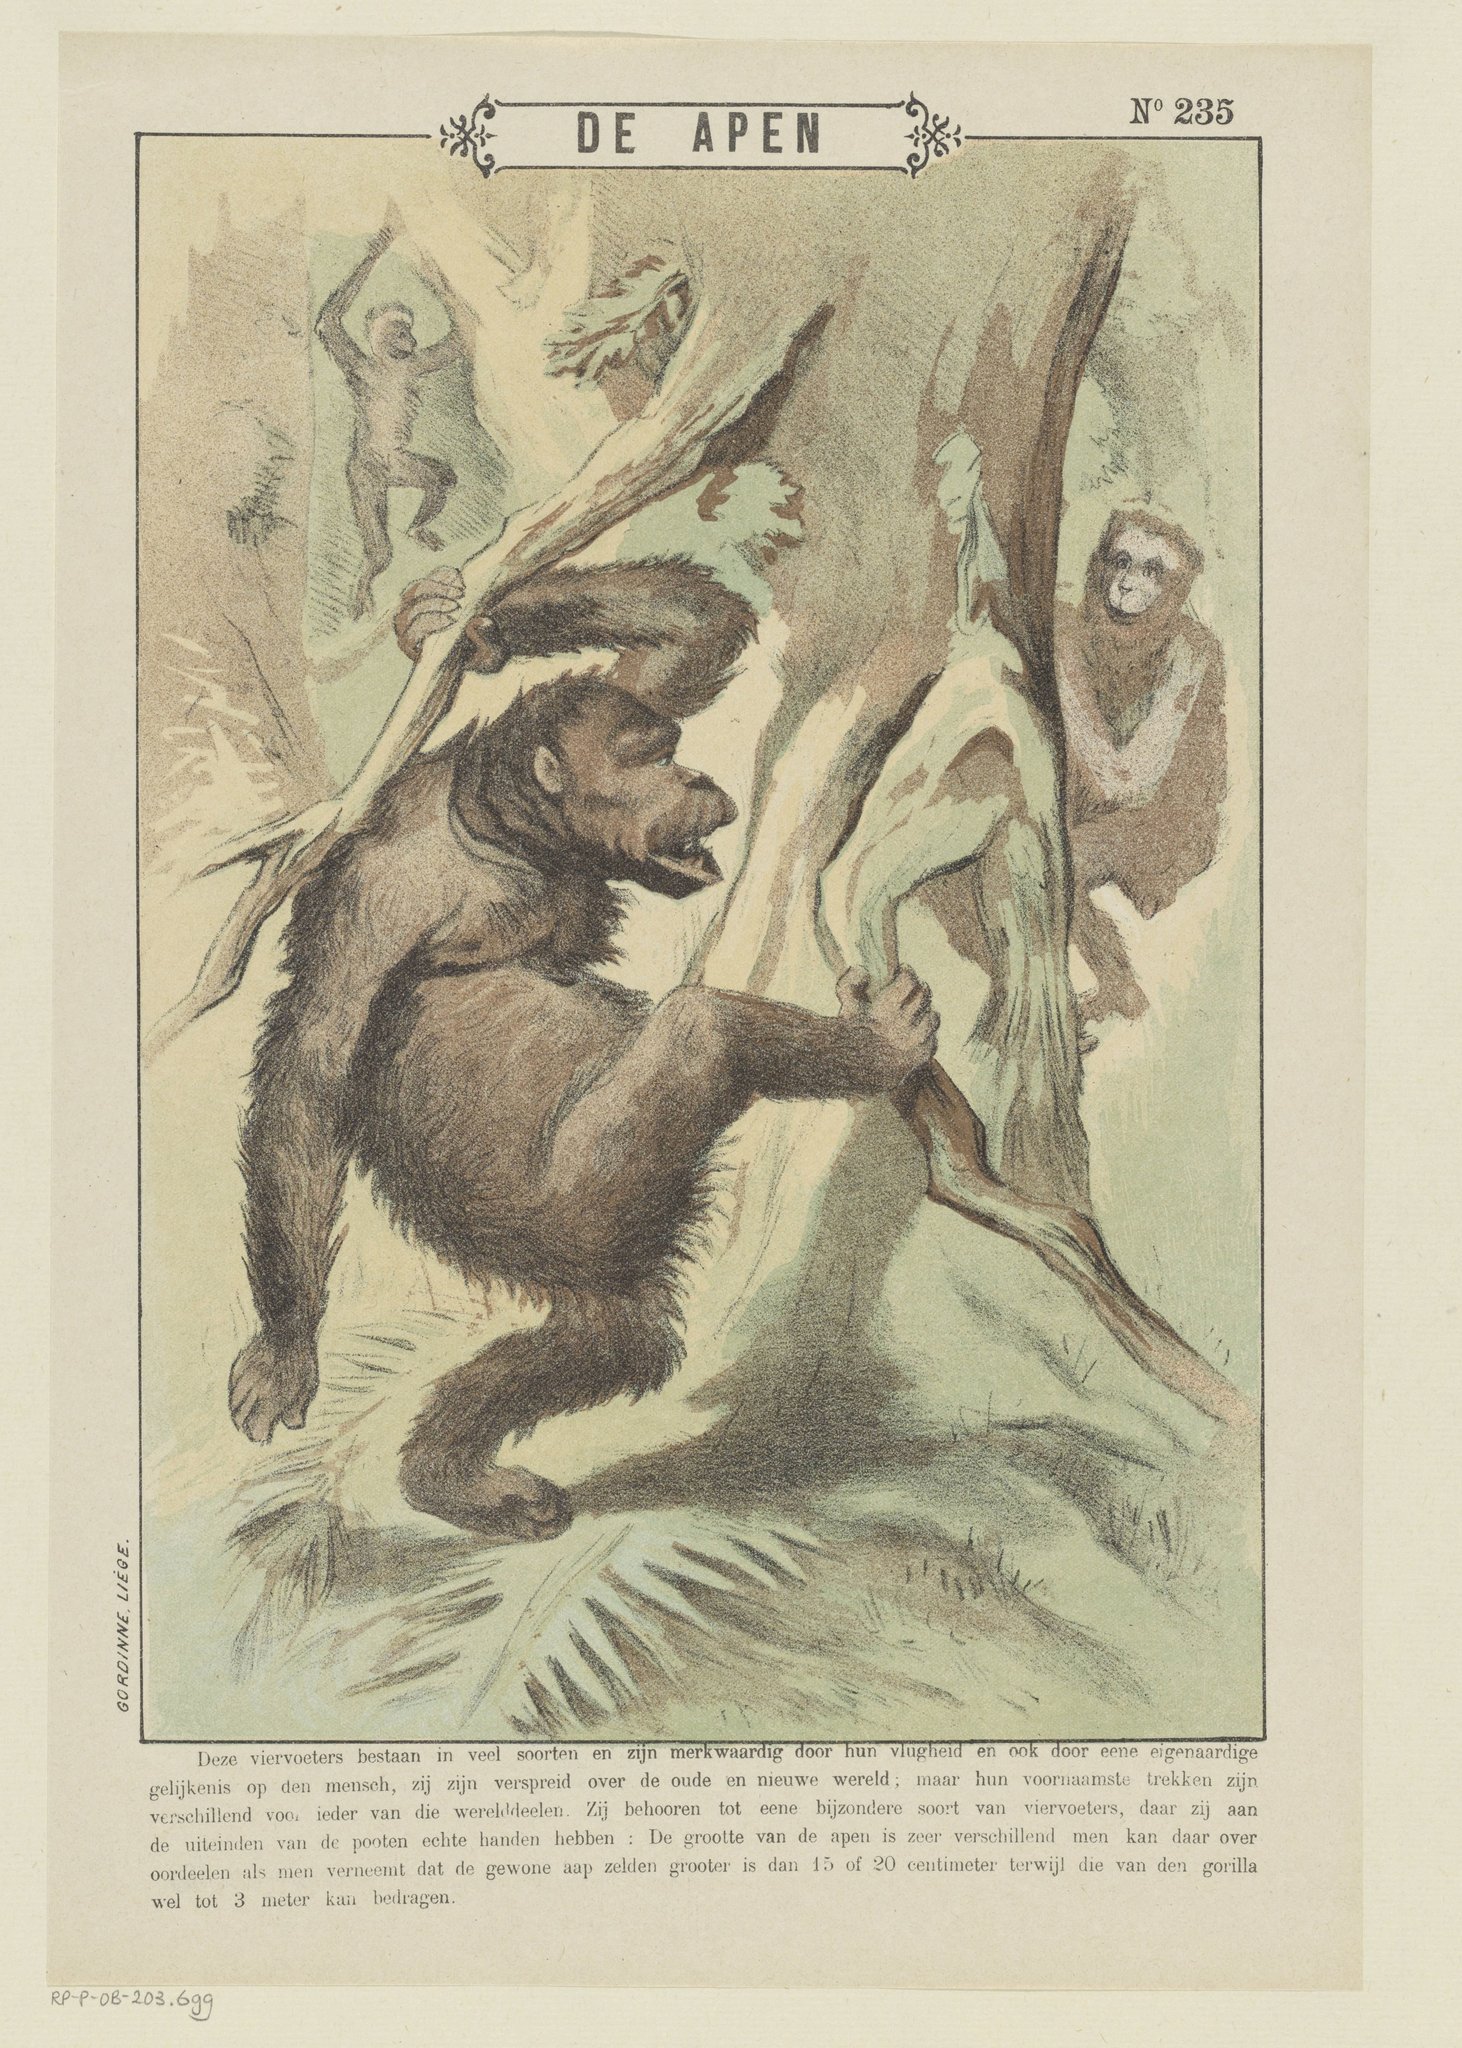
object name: popular print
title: De apen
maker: Anonymous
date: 1894-1959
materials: paper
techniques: lithograph, letterpress printing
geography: liège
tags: monkeys, apes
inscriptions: collector's mark: Lugt 2760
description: Blad met een grote voorstelling van apen in boomtakken. In de ondermarge een onderschrift. Genummerd rechtsboven: No 235.